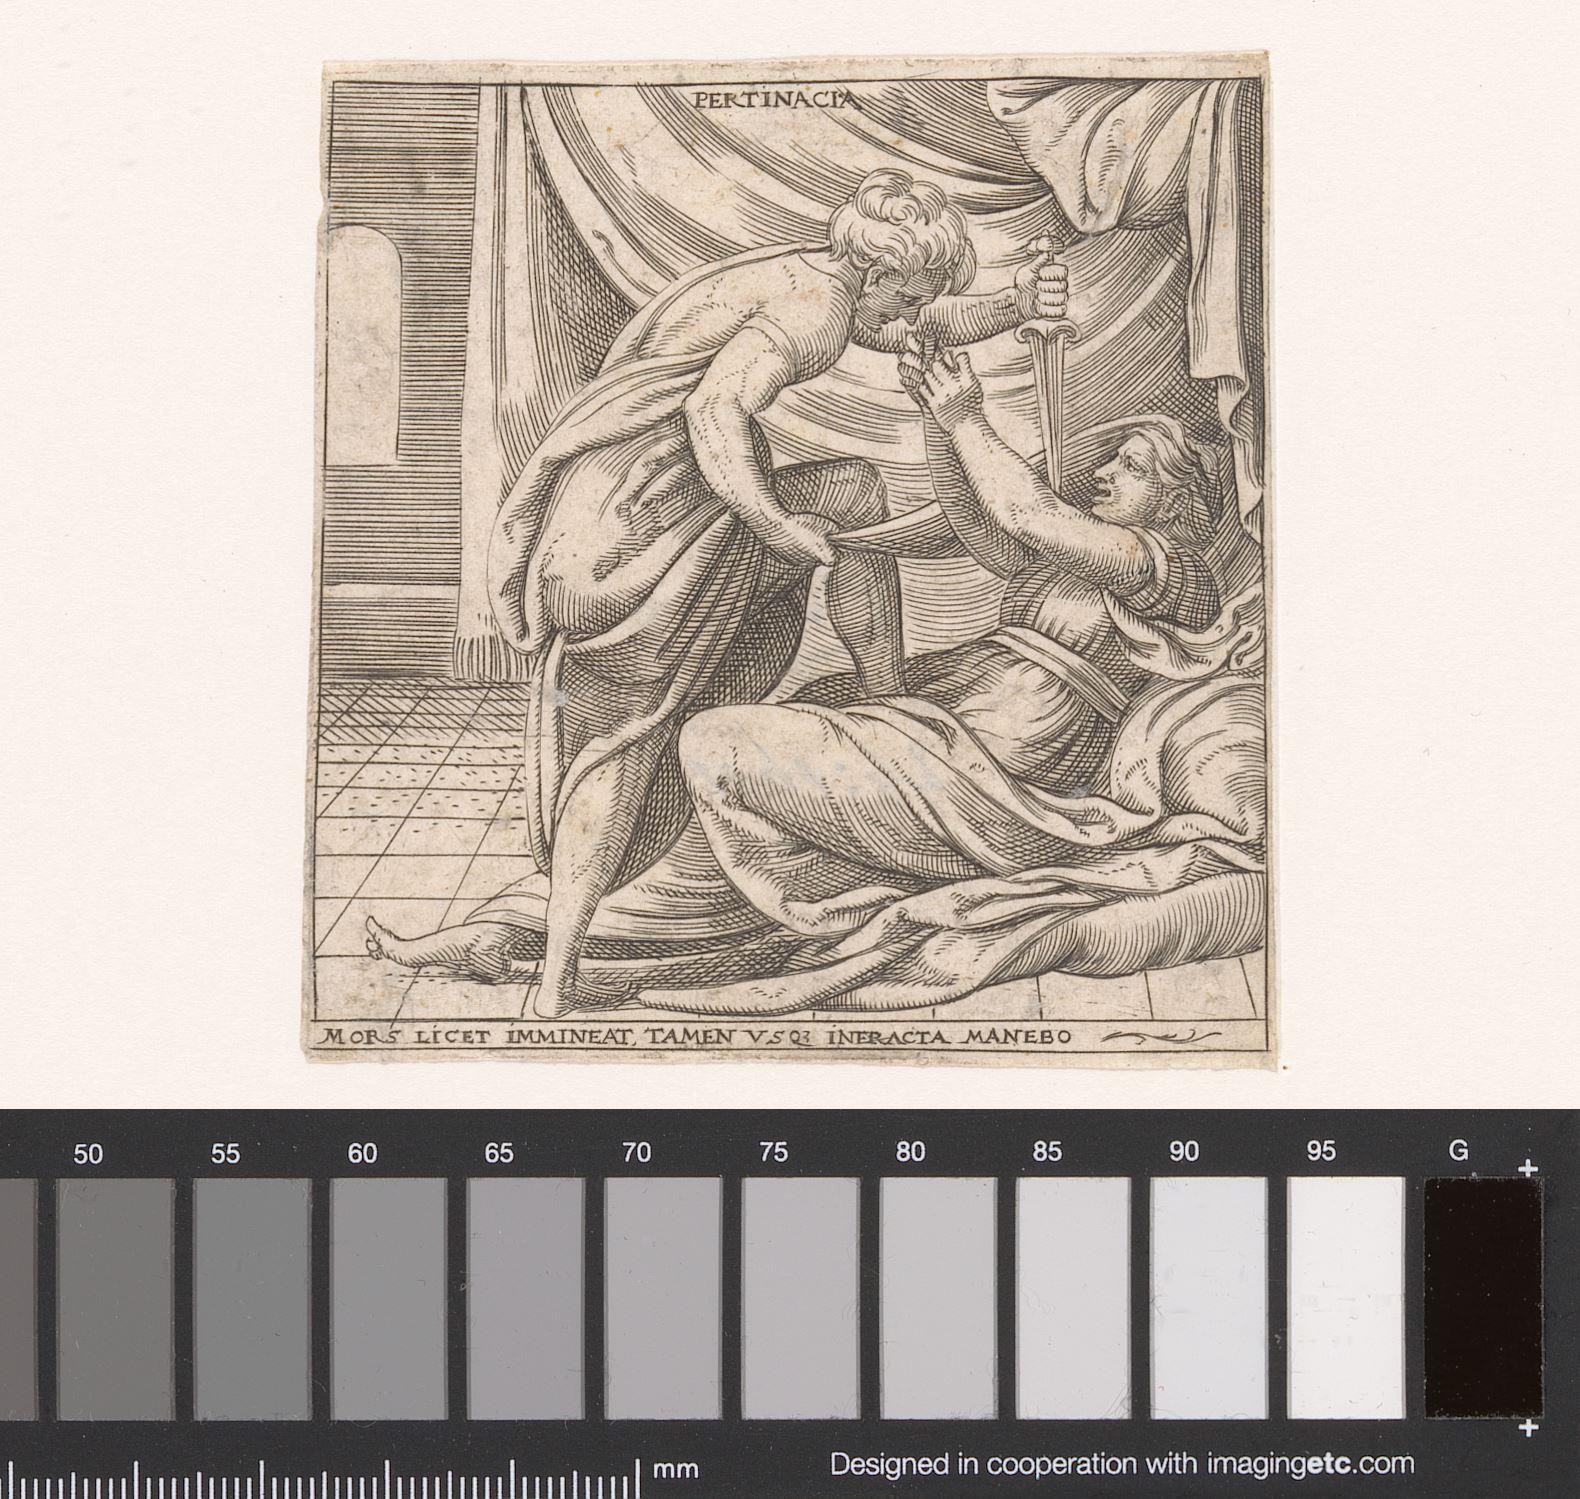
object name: print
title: Halsstarrigheid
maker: francesco salviati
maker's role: draughtsman, painter, print maker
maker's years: 1510-1563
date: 1533-1567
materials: paper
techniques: engraving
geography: italy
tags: obstinacy; 'ostinatione', 'pertinacia' (ripa)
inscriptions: collector's mark: Lugt 2228, number: ‘27’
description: Een man die een liggende vrouw bedreigt met een dolk, mogelijk Tarquinius en Lucretia. De vrouw verweert zich met haar handen. Regel Latijnse tekst in ondermarge.